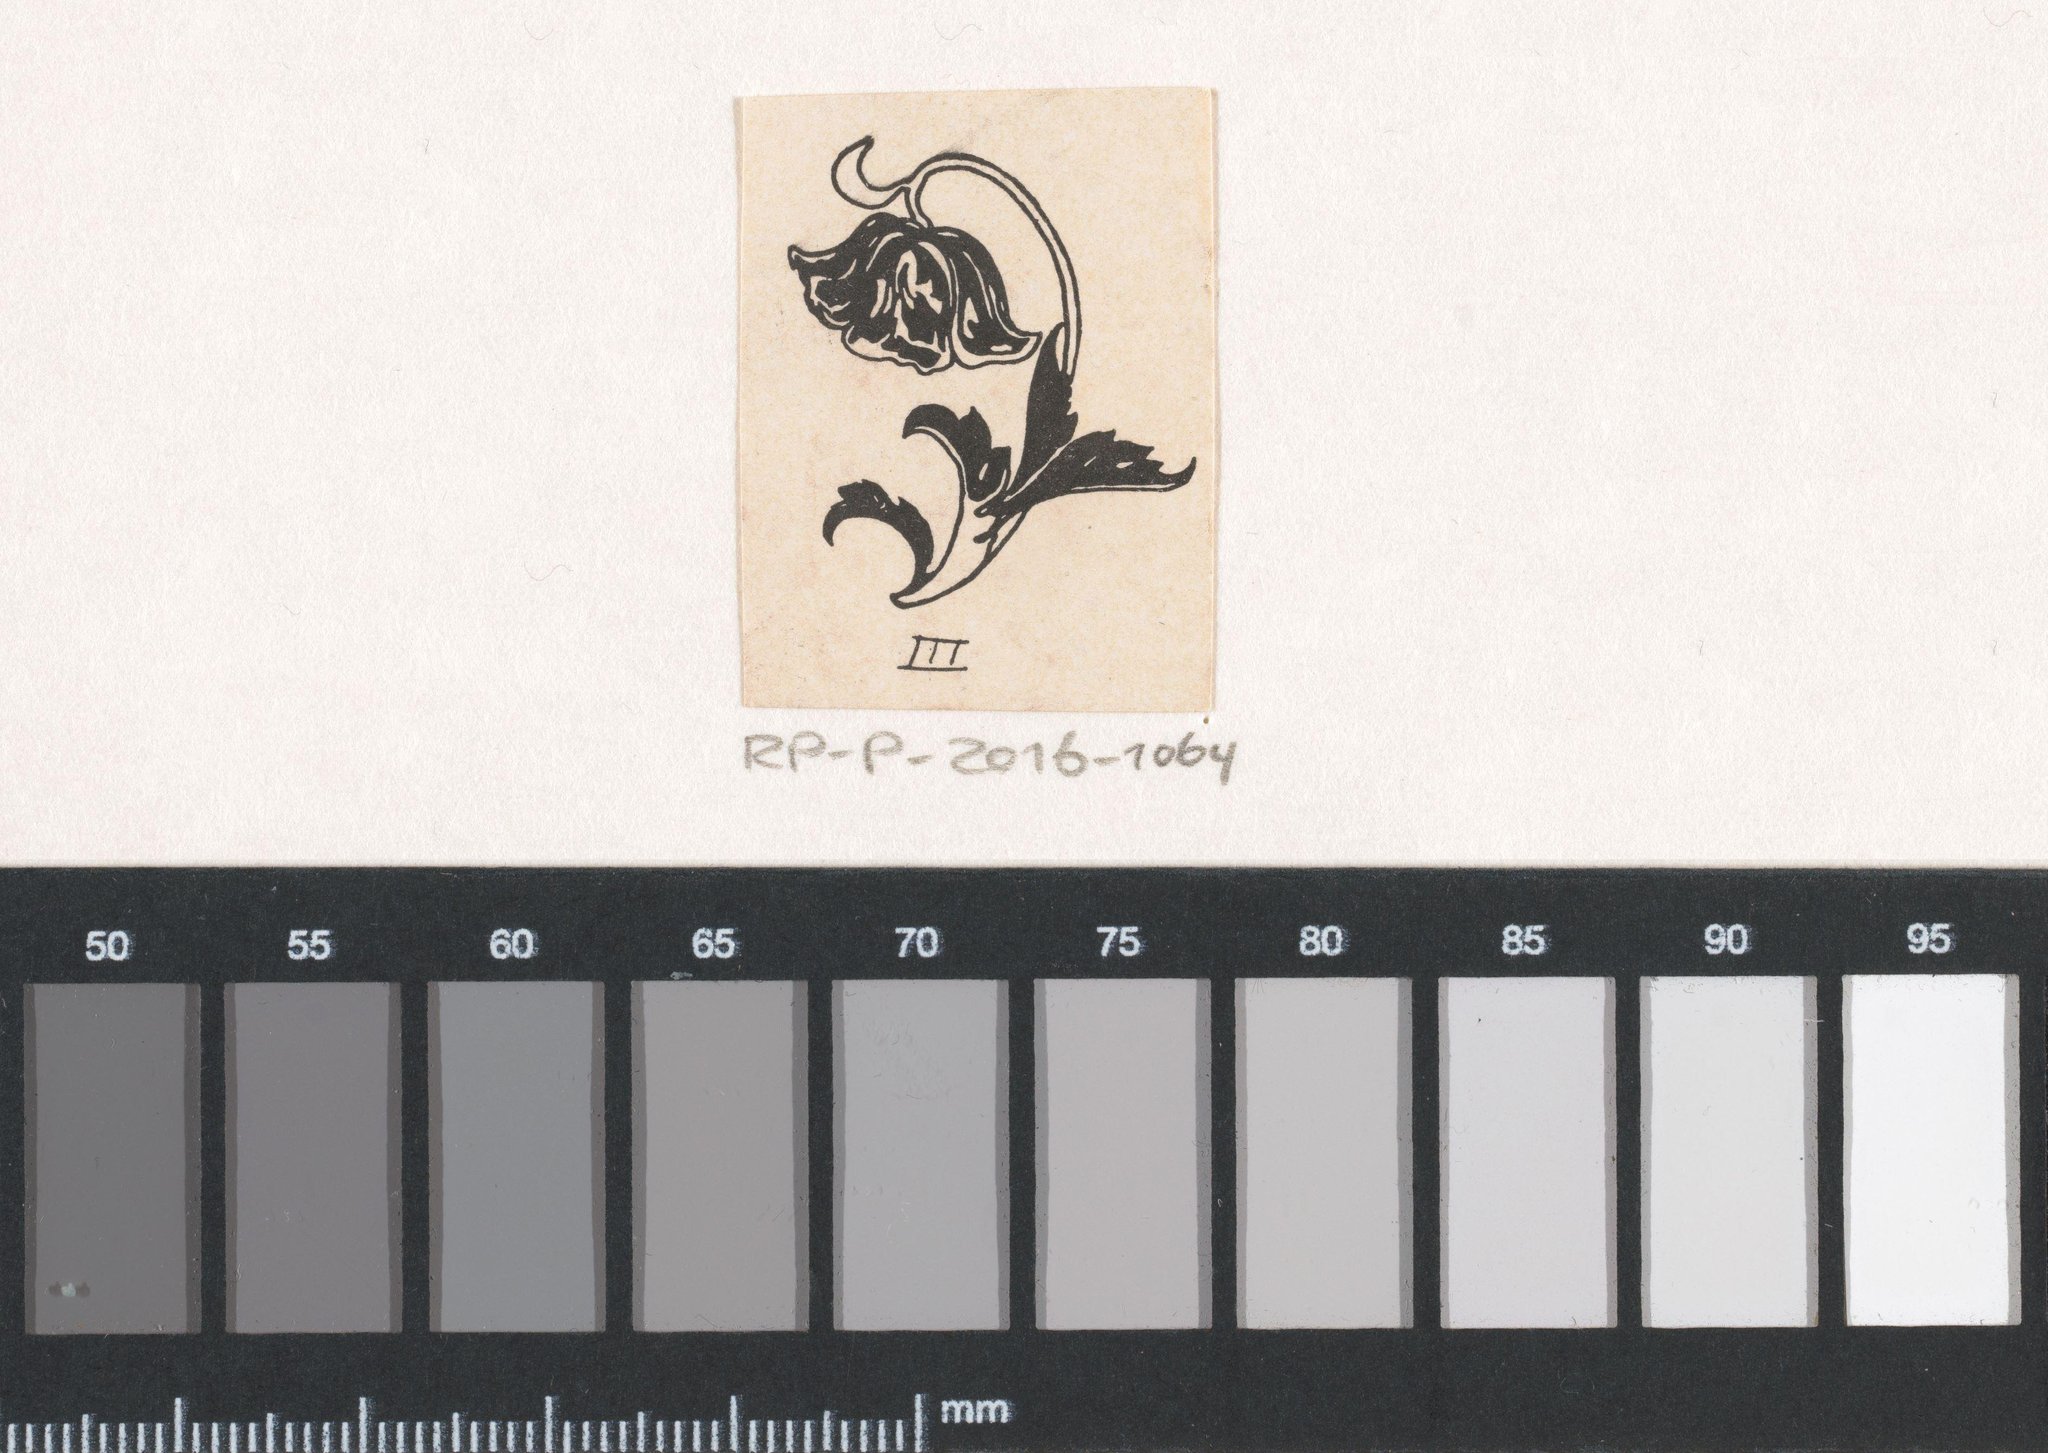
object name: photomechanical print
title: Ornament met tulp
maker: Anonymous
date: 1870-1937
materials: paper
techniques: printing block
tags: flowers ~ ornament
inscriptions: number: ‘III’